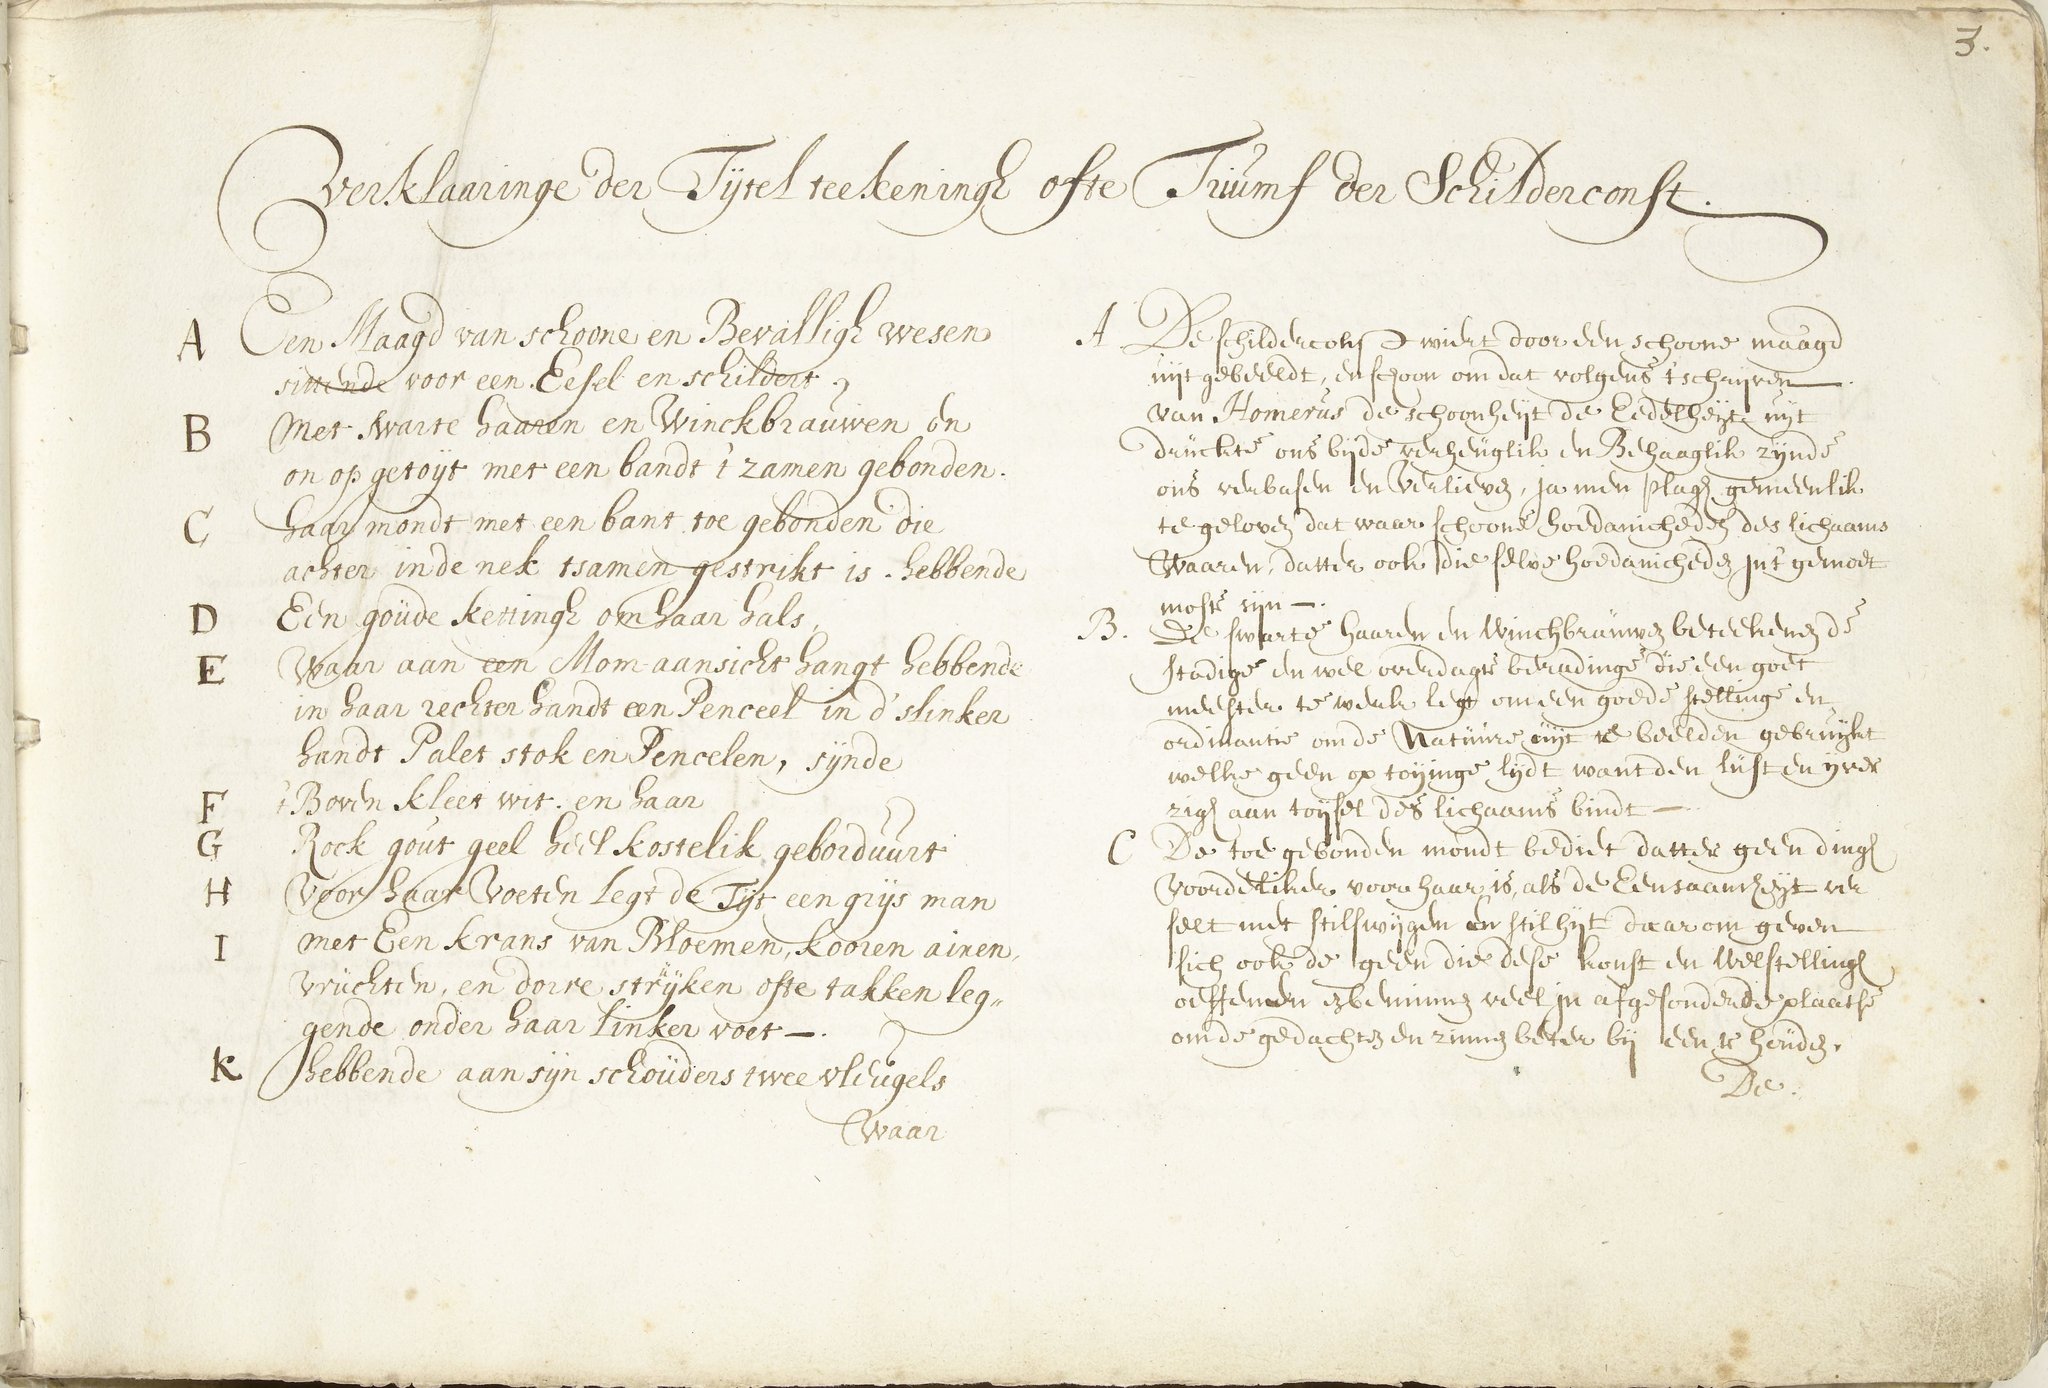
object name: text sheet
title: Verklaaringe der Tijtel teekeningh ofte Triumf der Schilderconst.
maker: henrik jordis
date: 1660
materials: ink, paper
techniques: writing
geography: zwolle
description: Verklaring van de titelpagina met De overwinning van de Schilderkunst over de Dood (BI-1887-1463-2), in twee kolommen.